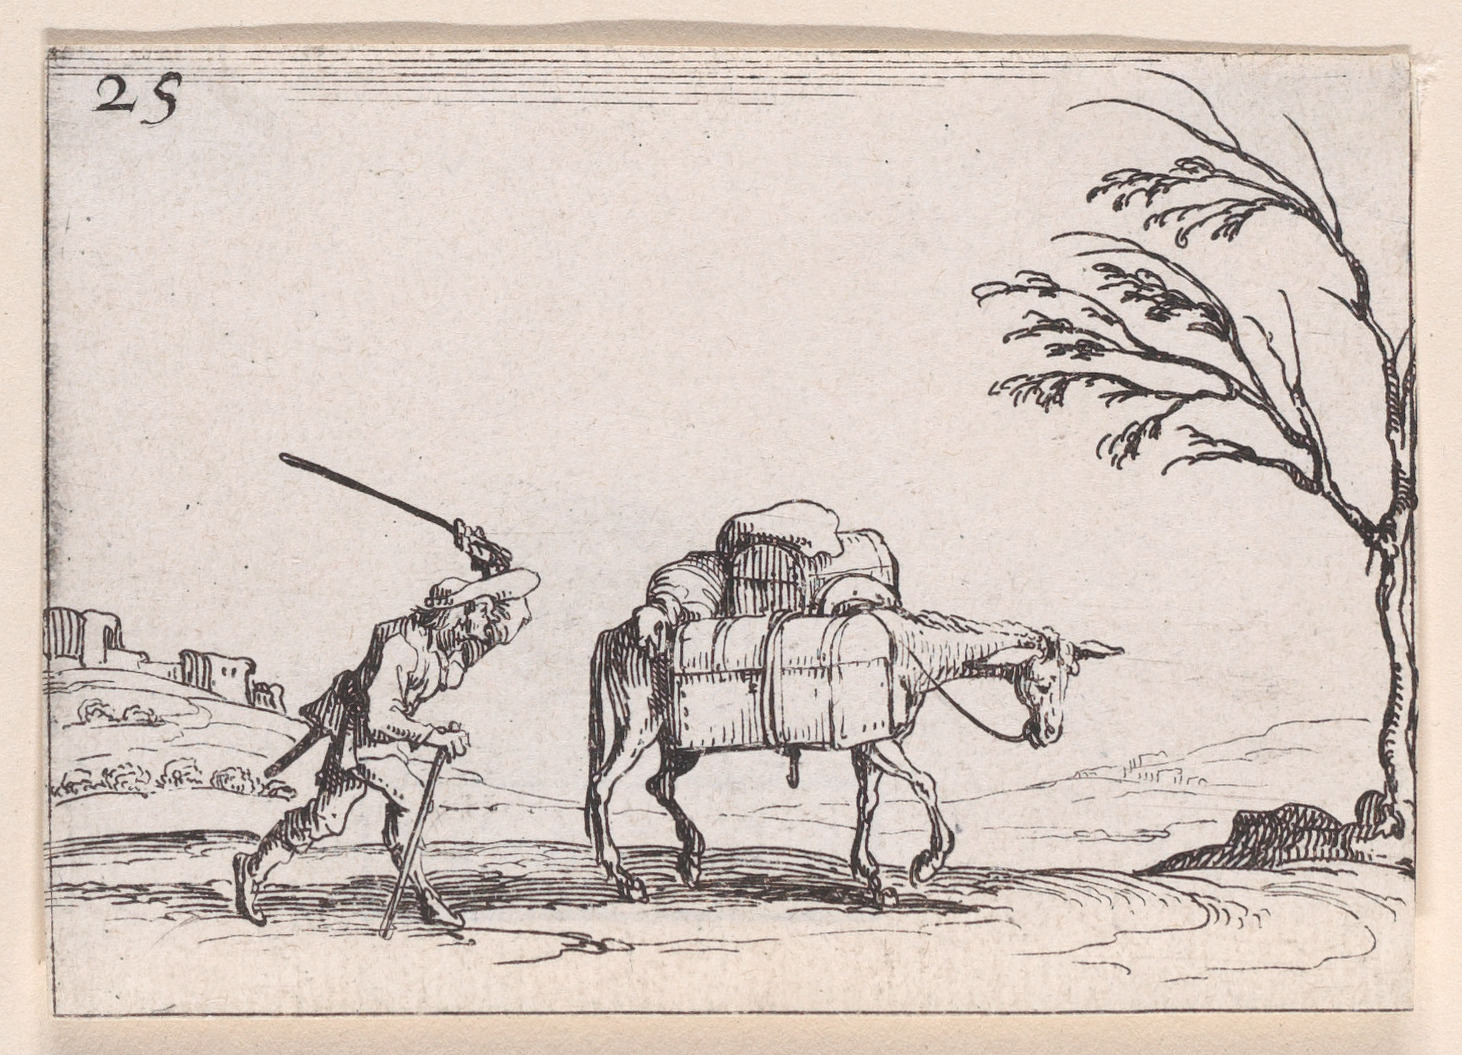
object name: print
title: Le Paysan Frappant son Ane (The Peasant Striking his Donkey), plate 25 from "Lux Claustri ou La Lumière du Cloitre" (The Light of the Cloisters)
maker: jacques callot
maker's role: artist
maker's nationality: french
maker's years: 1592-1635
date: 1621-1635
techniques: etching